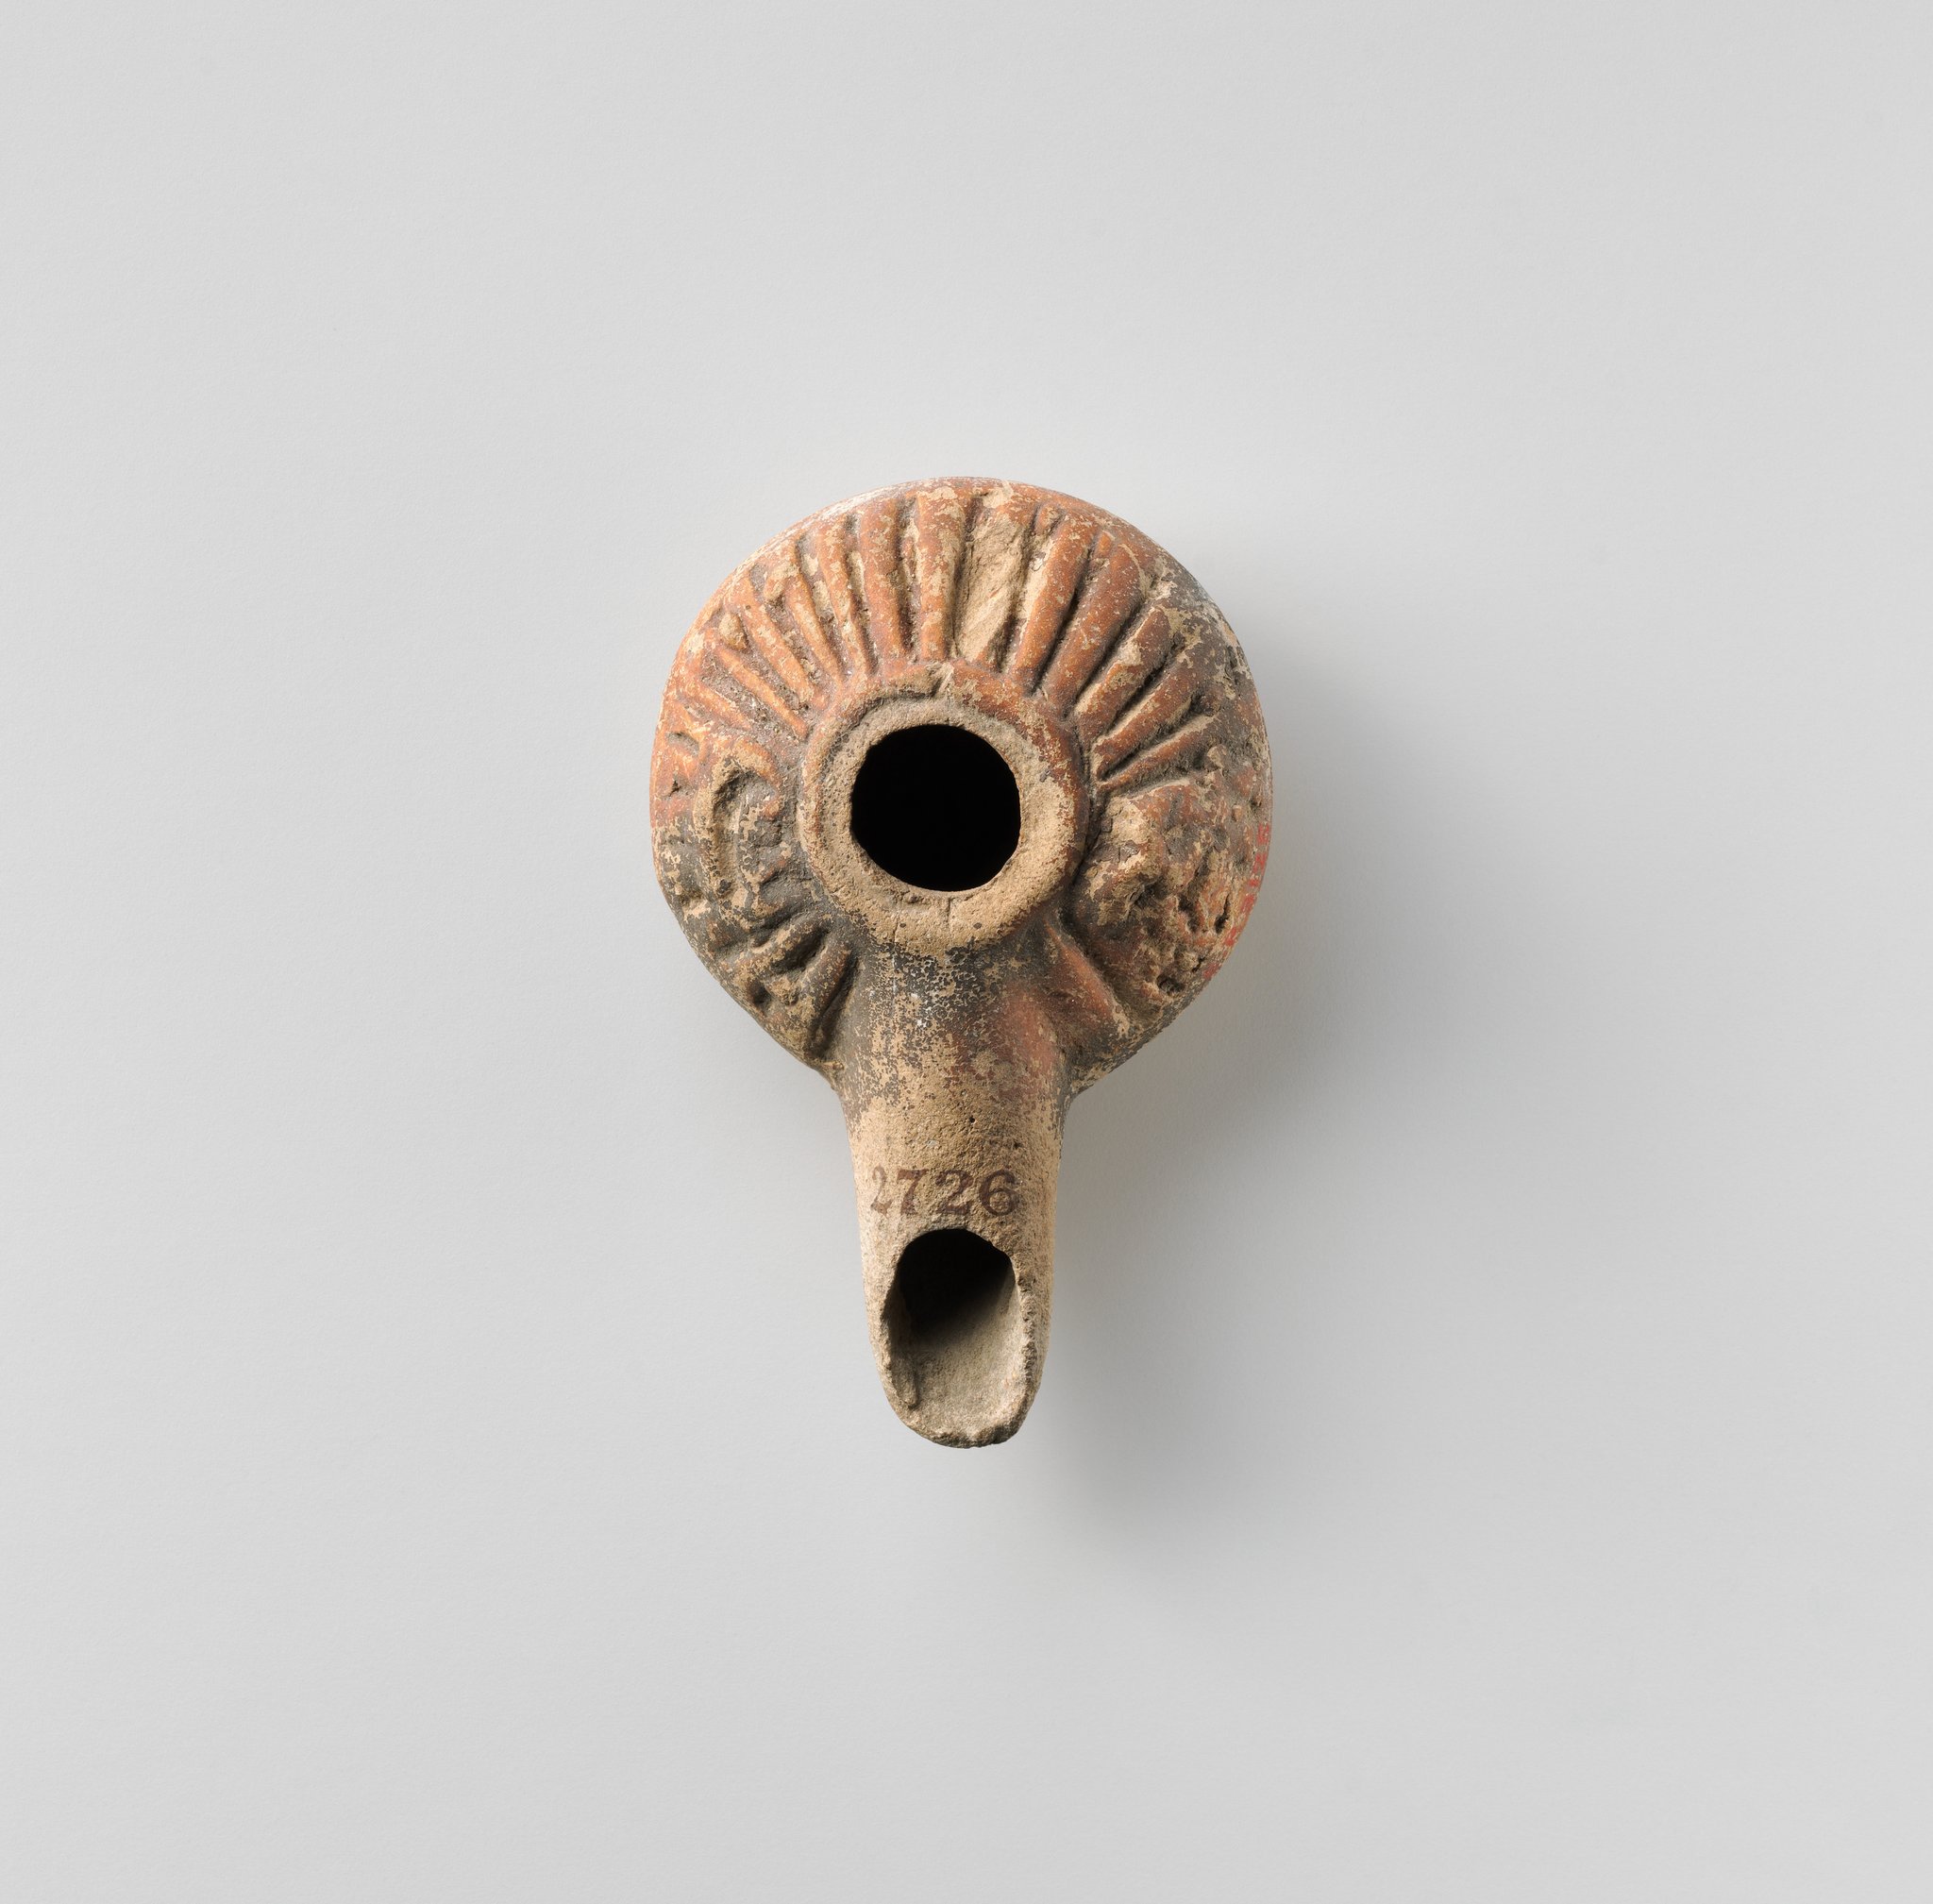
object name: lamp, convex top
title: Terracotta oil lamp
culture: greek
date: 7000 BCE-330 CE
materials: terracotta